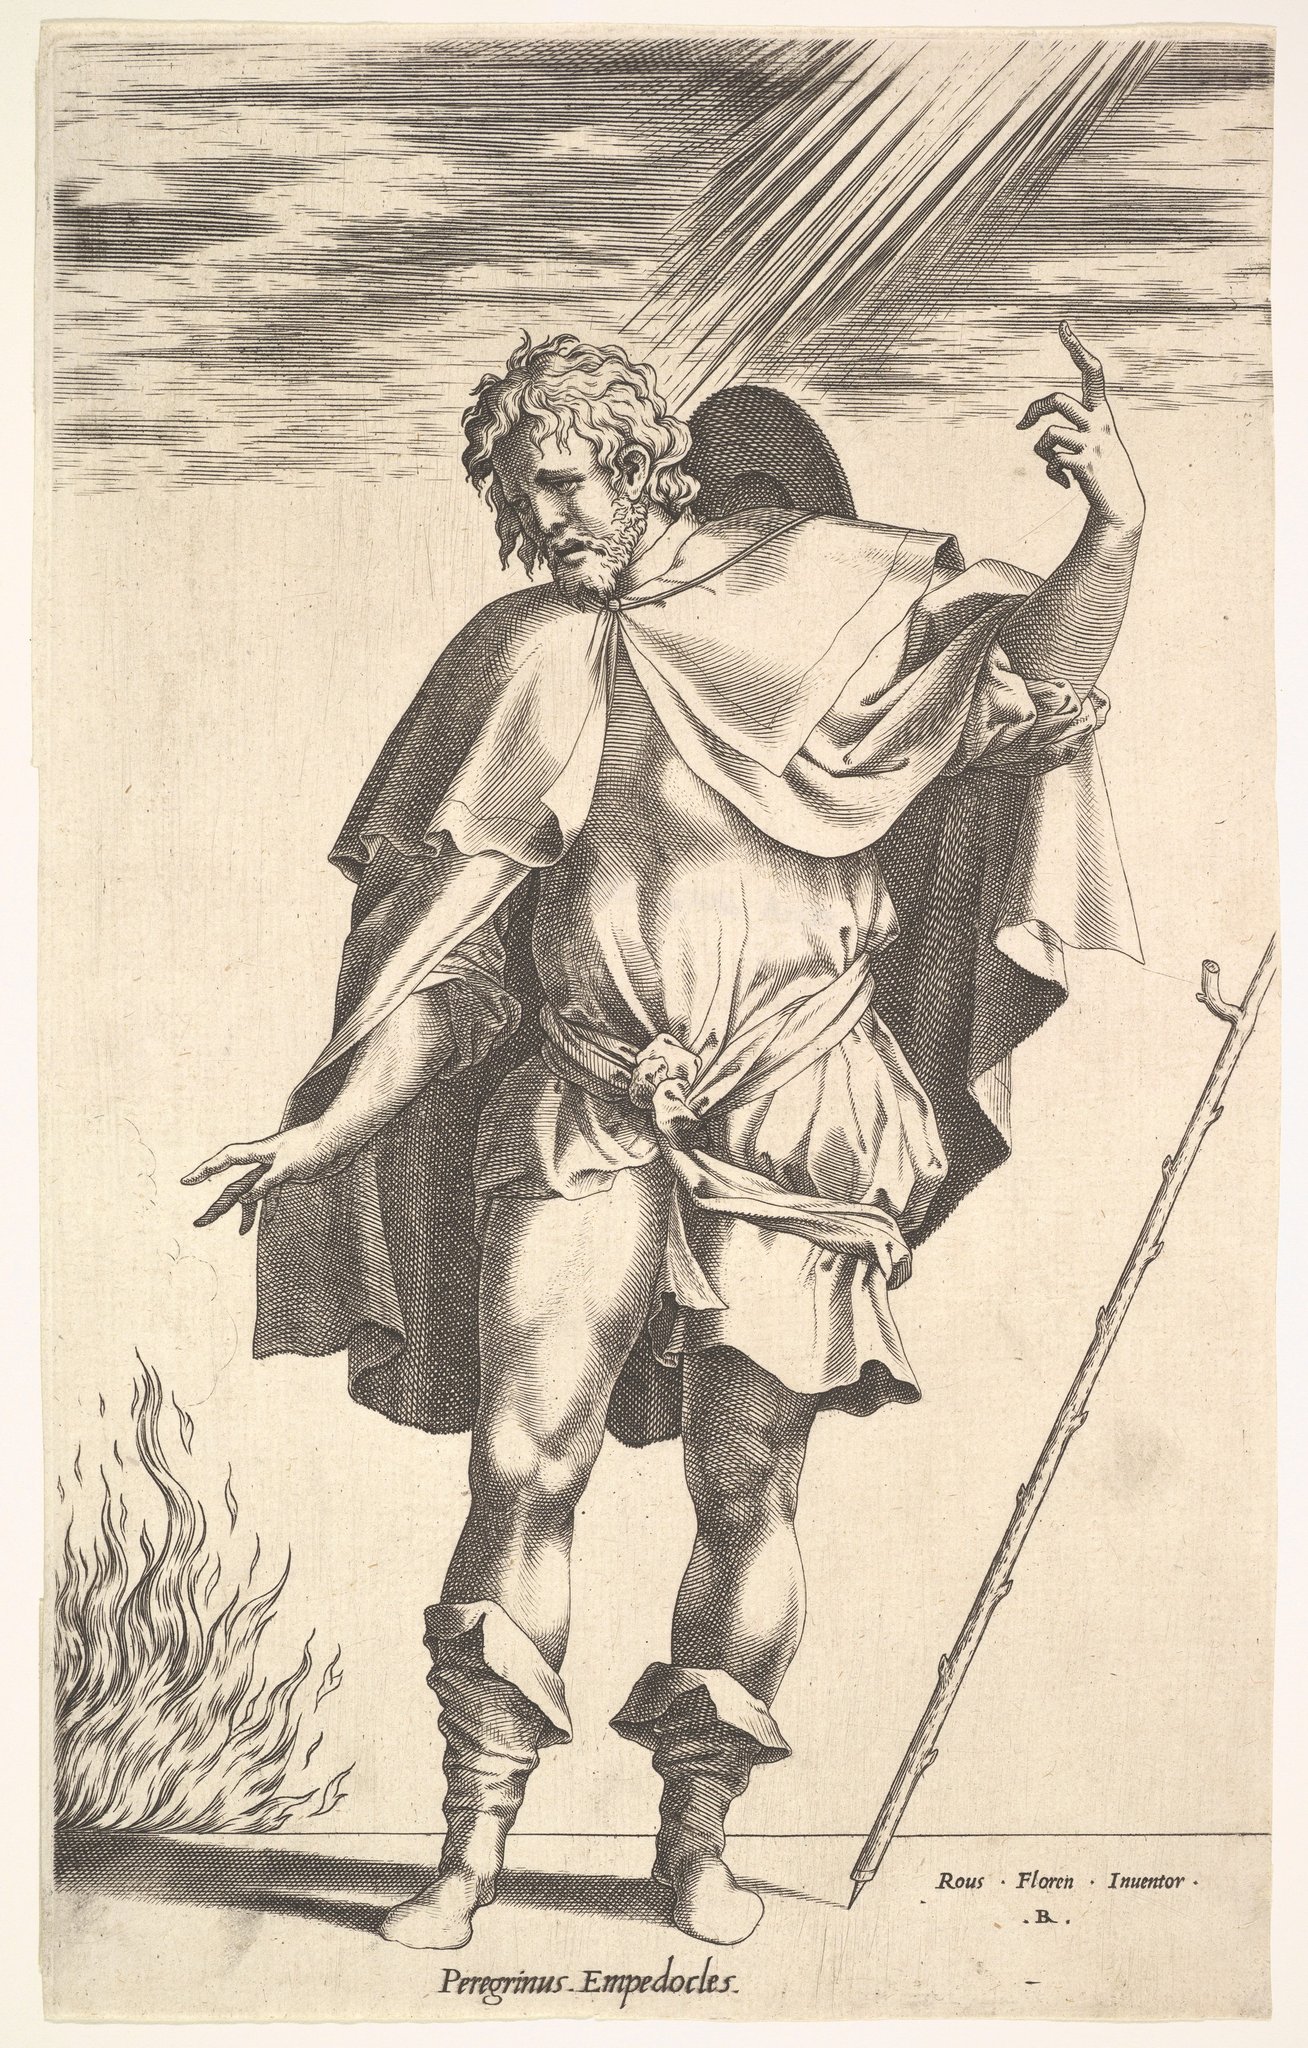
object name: print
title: Empedocles, standing frontally with his head turned in three-quarter view, directs his gaze toward a flame (the crater of Mount Aetna?) emerging from a horizontal ground line, a walking stick leans toward the right margin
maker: rené boyvin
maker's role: artist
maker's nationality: french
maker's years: 1525-1598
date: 1545-1563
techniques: engraving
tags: men,philosophers